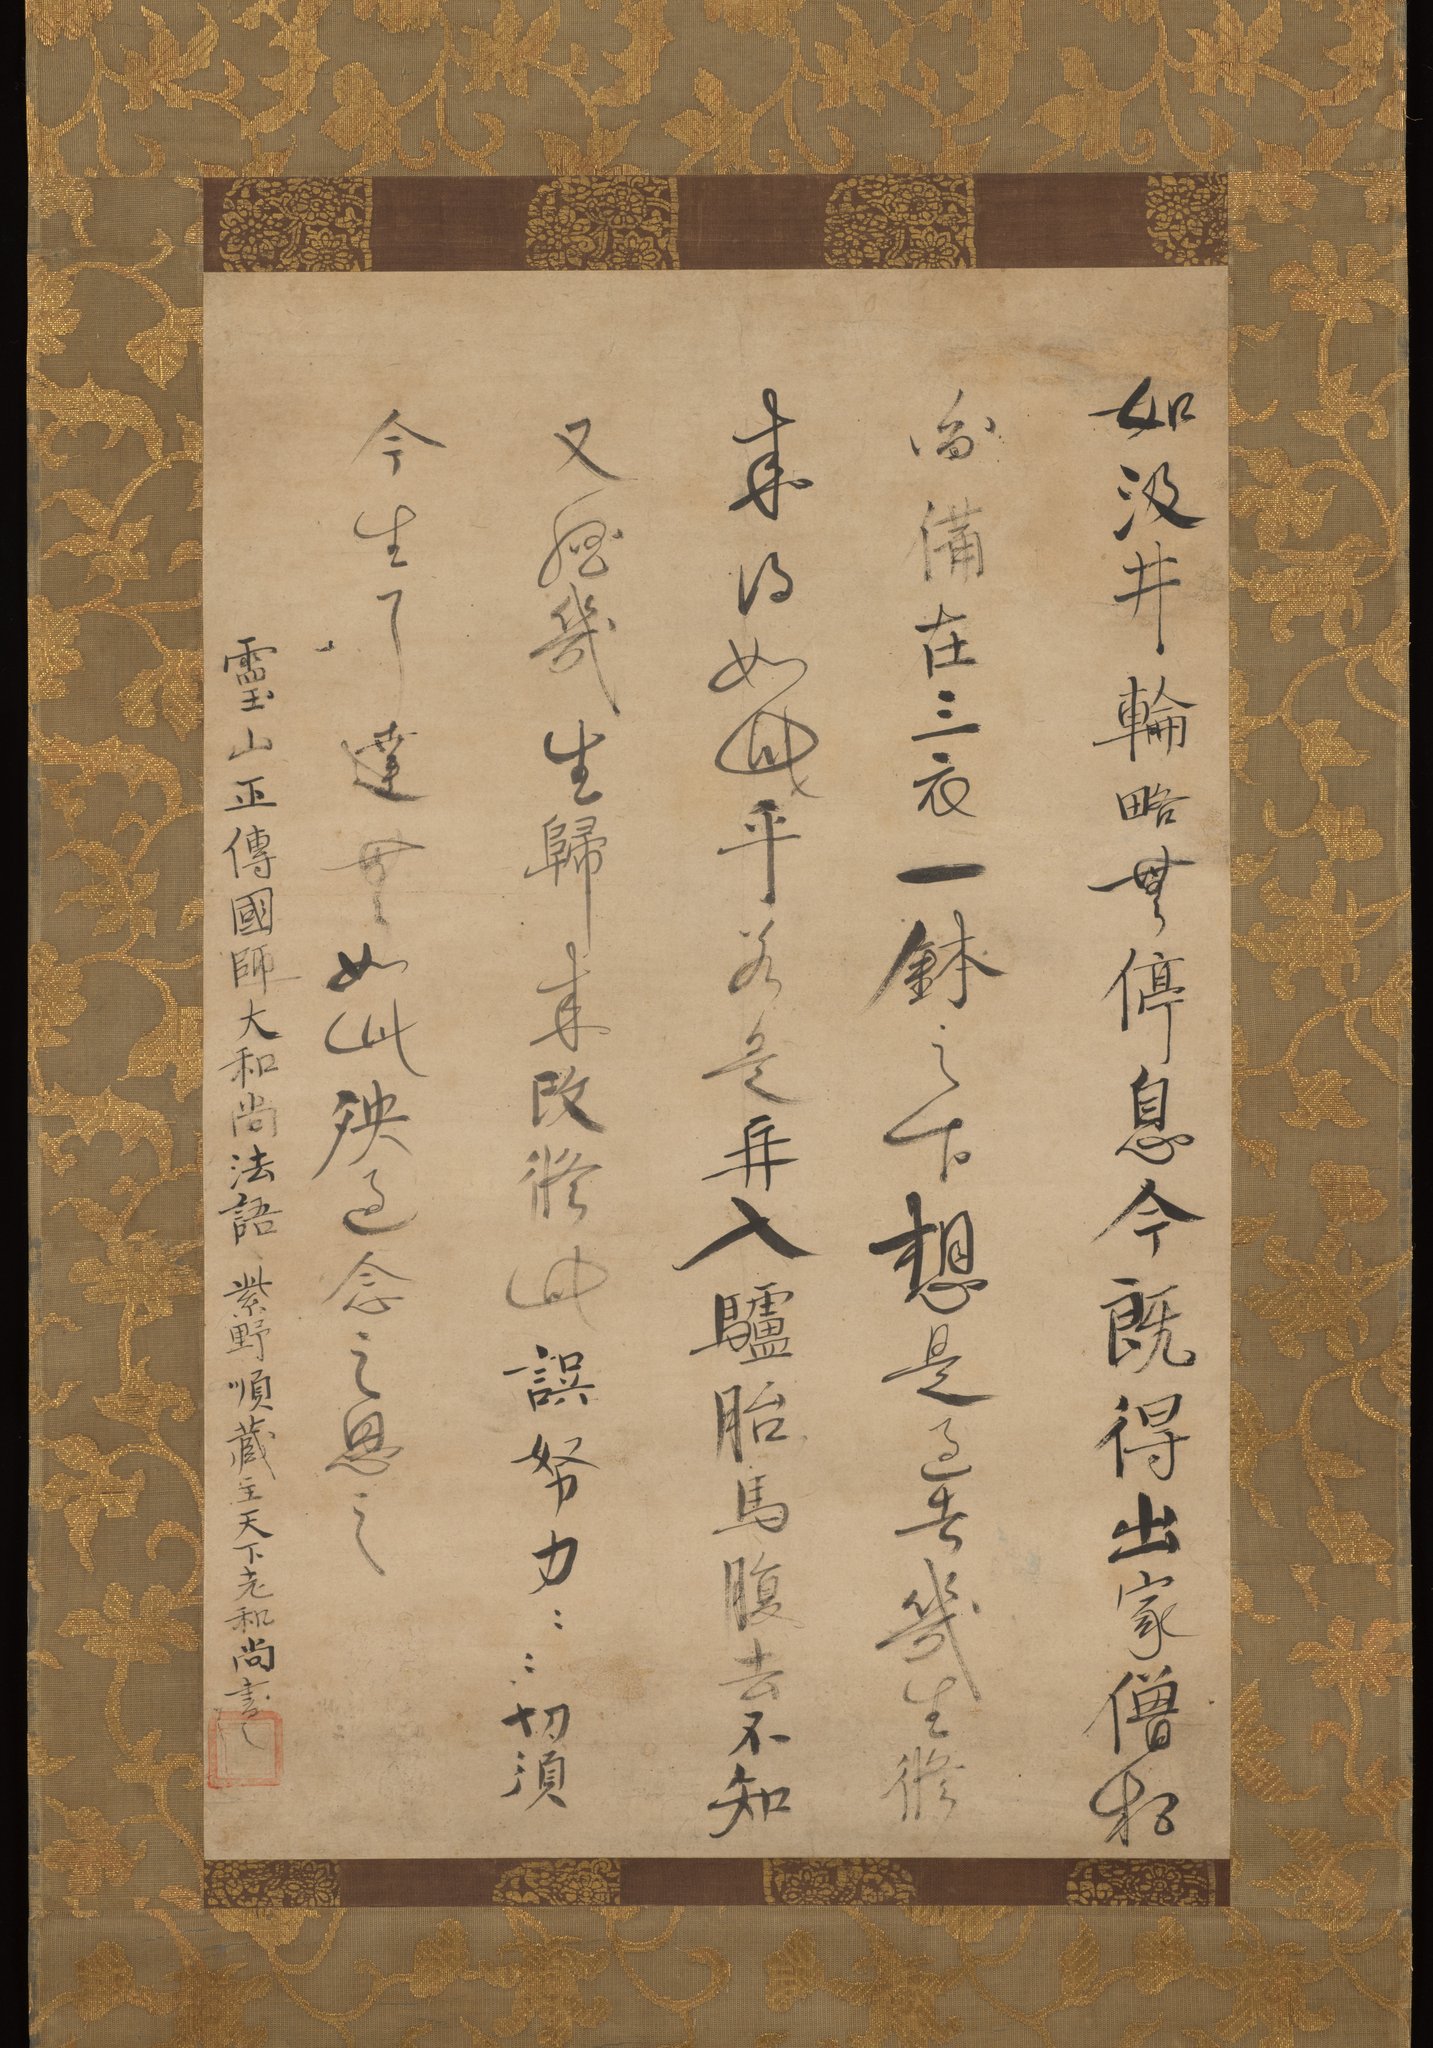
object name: hanging scroll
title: Discussion of Buddhist Principles by Tettō Gikō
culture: japanese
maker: ikkyū sōjun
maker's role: artist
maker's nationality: japanese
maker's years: 1394-1481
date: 1467-1500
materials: ink, paper